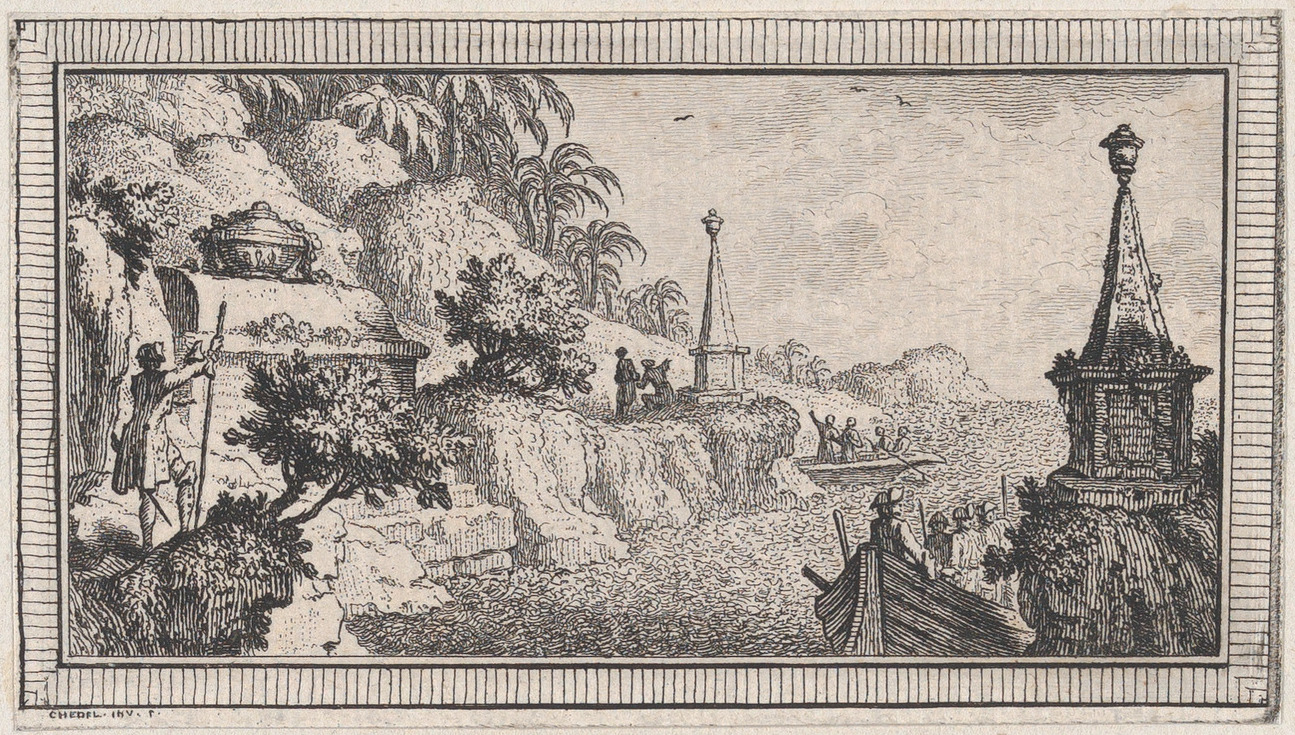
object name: print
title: Landscape, from a series of six landscapes titled "Observationib.Astronom.Regiae.Paris.Scient. Acad...1736"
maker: quentin pierre chedel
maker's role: artist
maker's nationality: french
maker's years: 1705-1763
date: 1736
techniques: etching